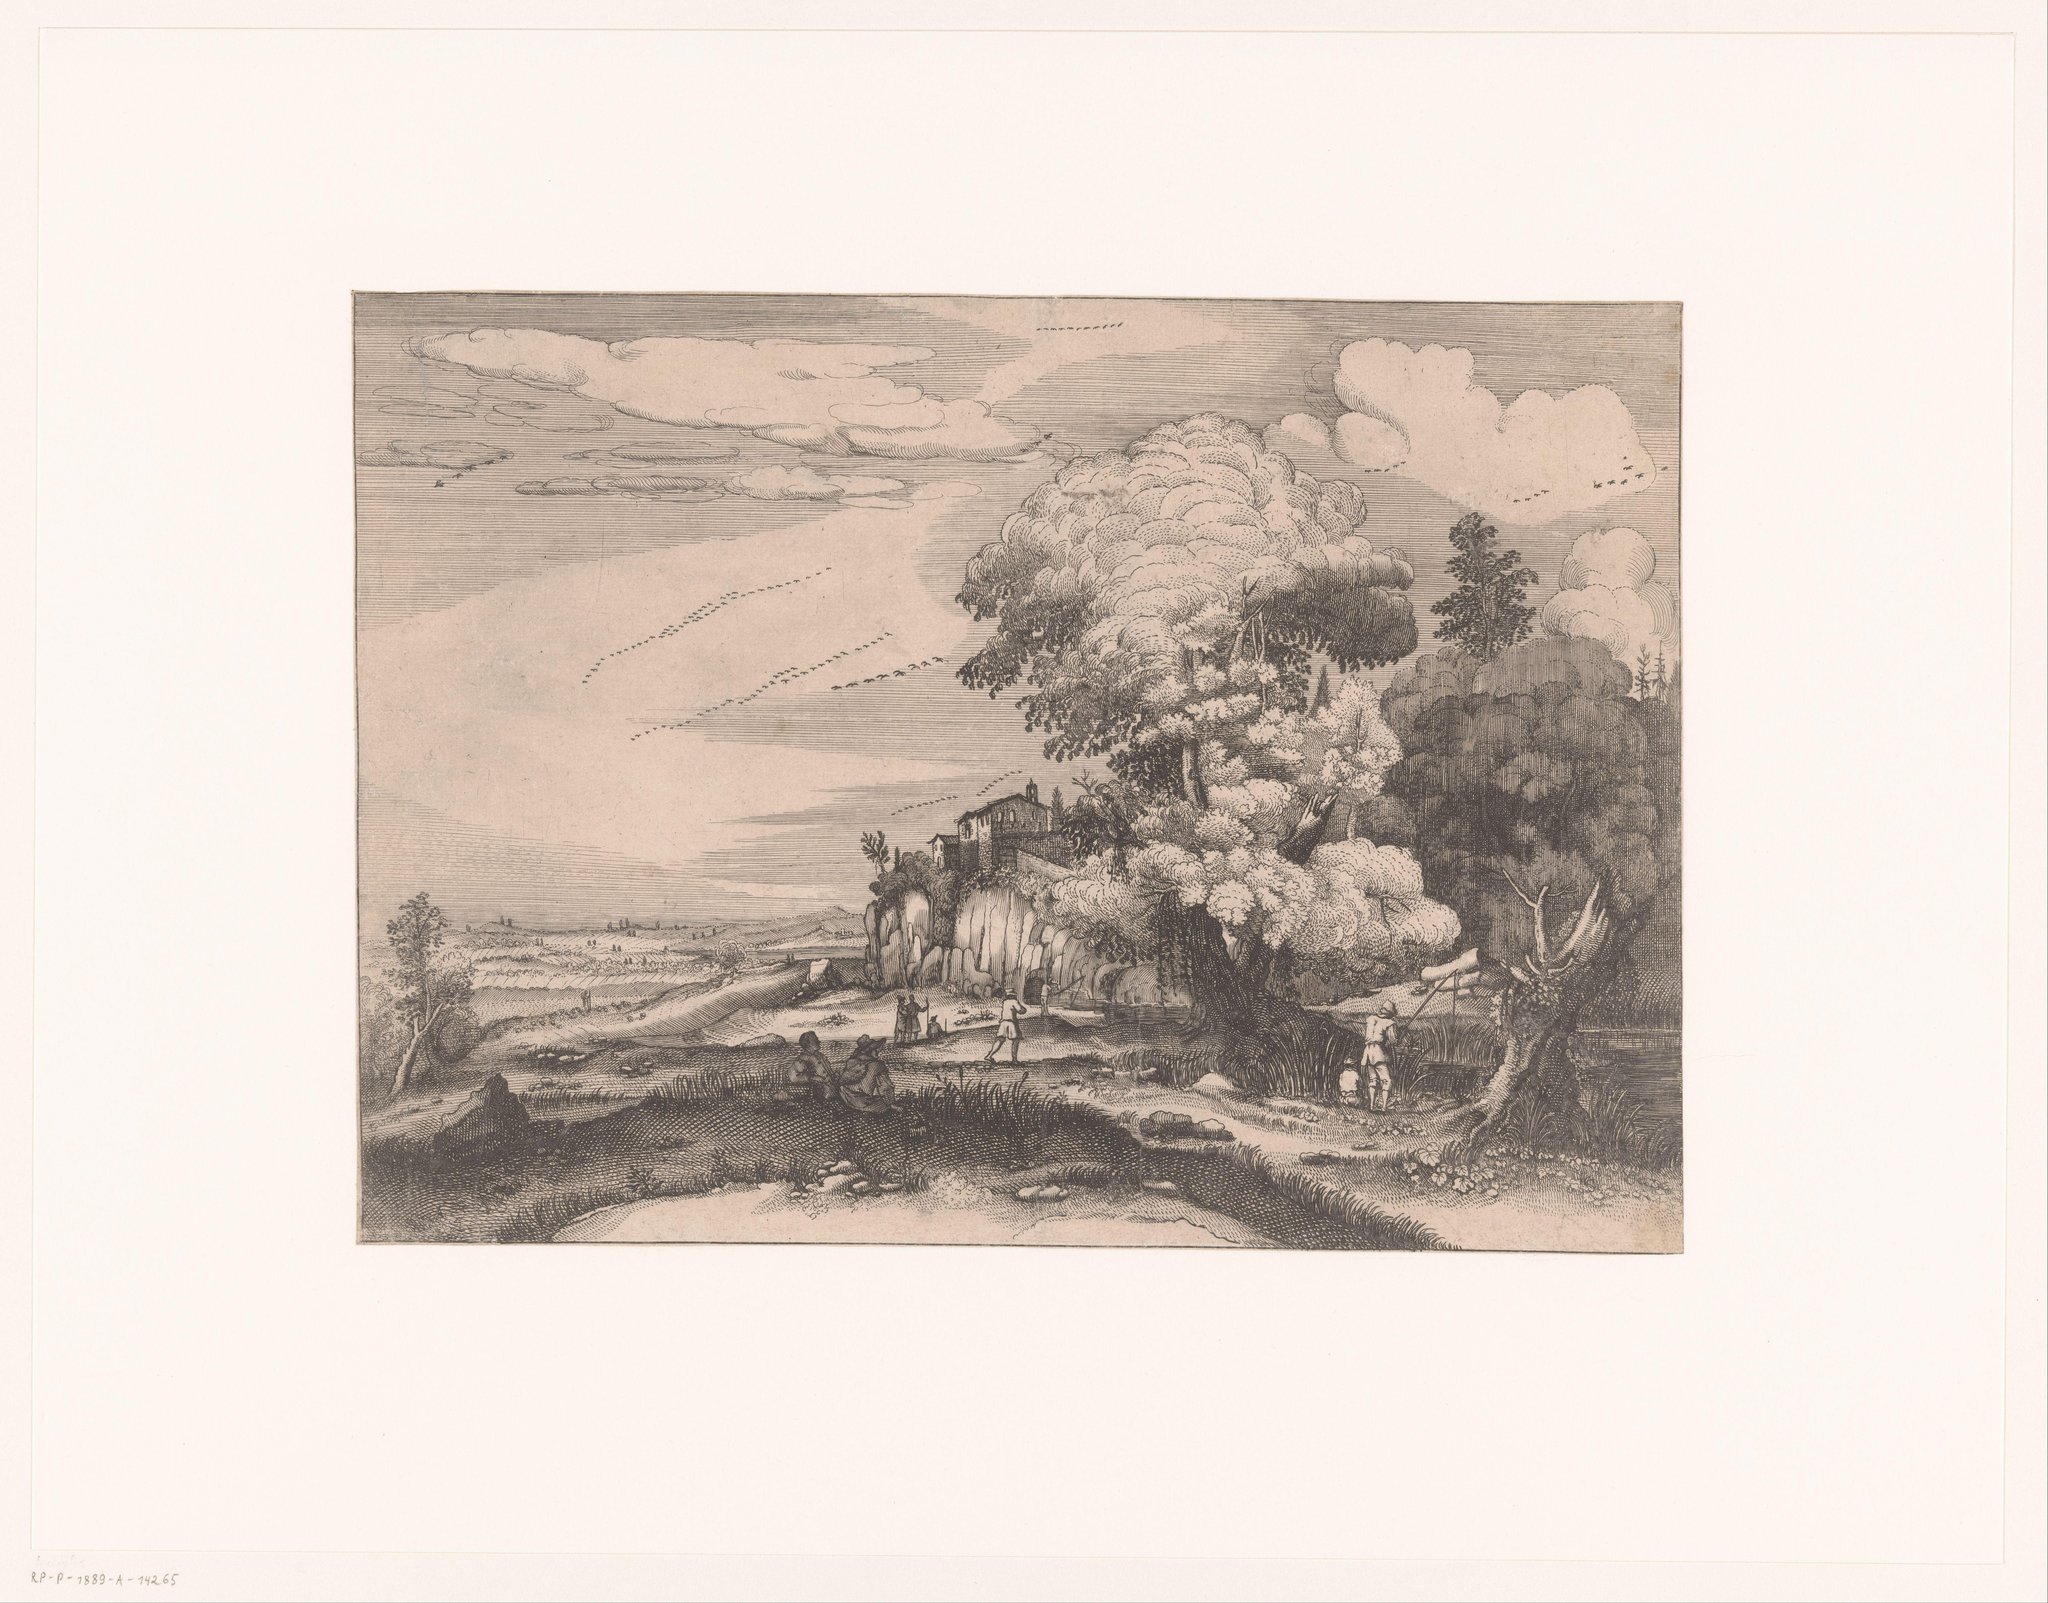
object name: print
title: Landschap met vissers en rustende figuren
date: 1610-1644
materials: paper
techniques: etching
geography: paris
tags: water course, fisherman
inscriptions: collector's mark: Lugt 2228